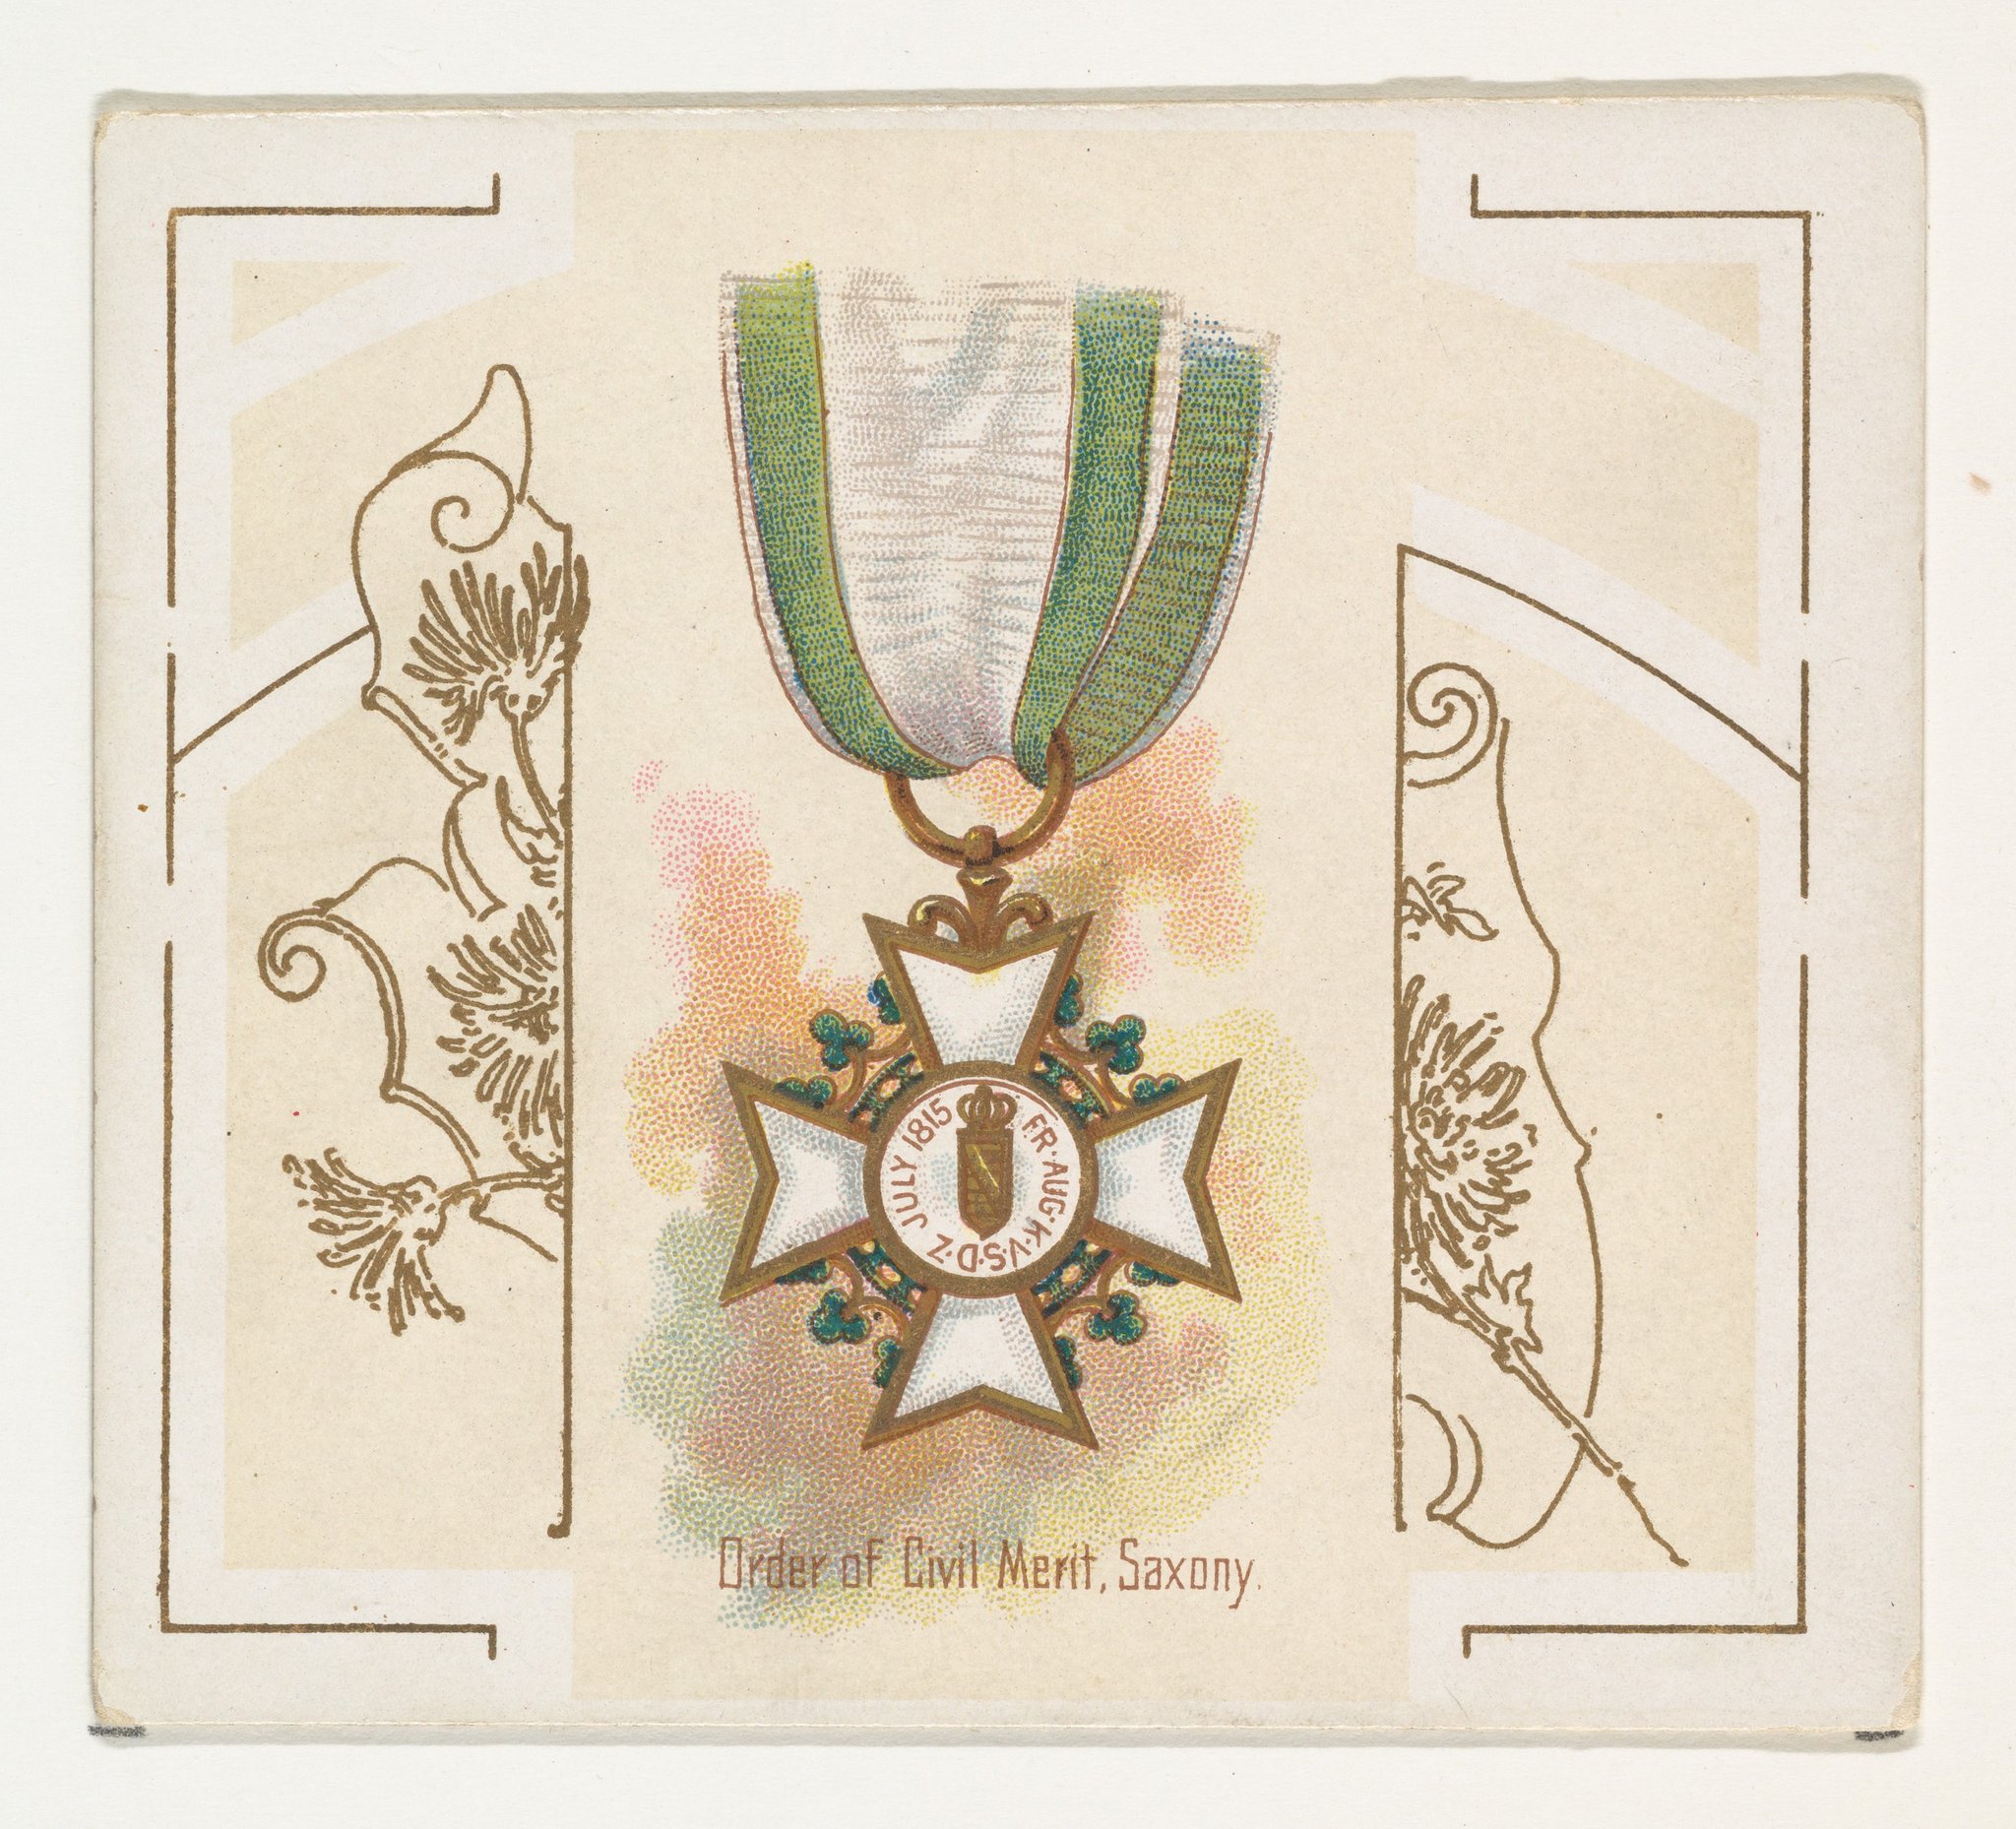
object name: print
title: Order of Civil Merit, Saxony, from the World's Decorations series (N44) for Allen & Ginter Cigarettes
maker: allen & ginter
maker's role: publisher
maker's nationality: american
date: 1890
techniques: color lithograph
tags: medals